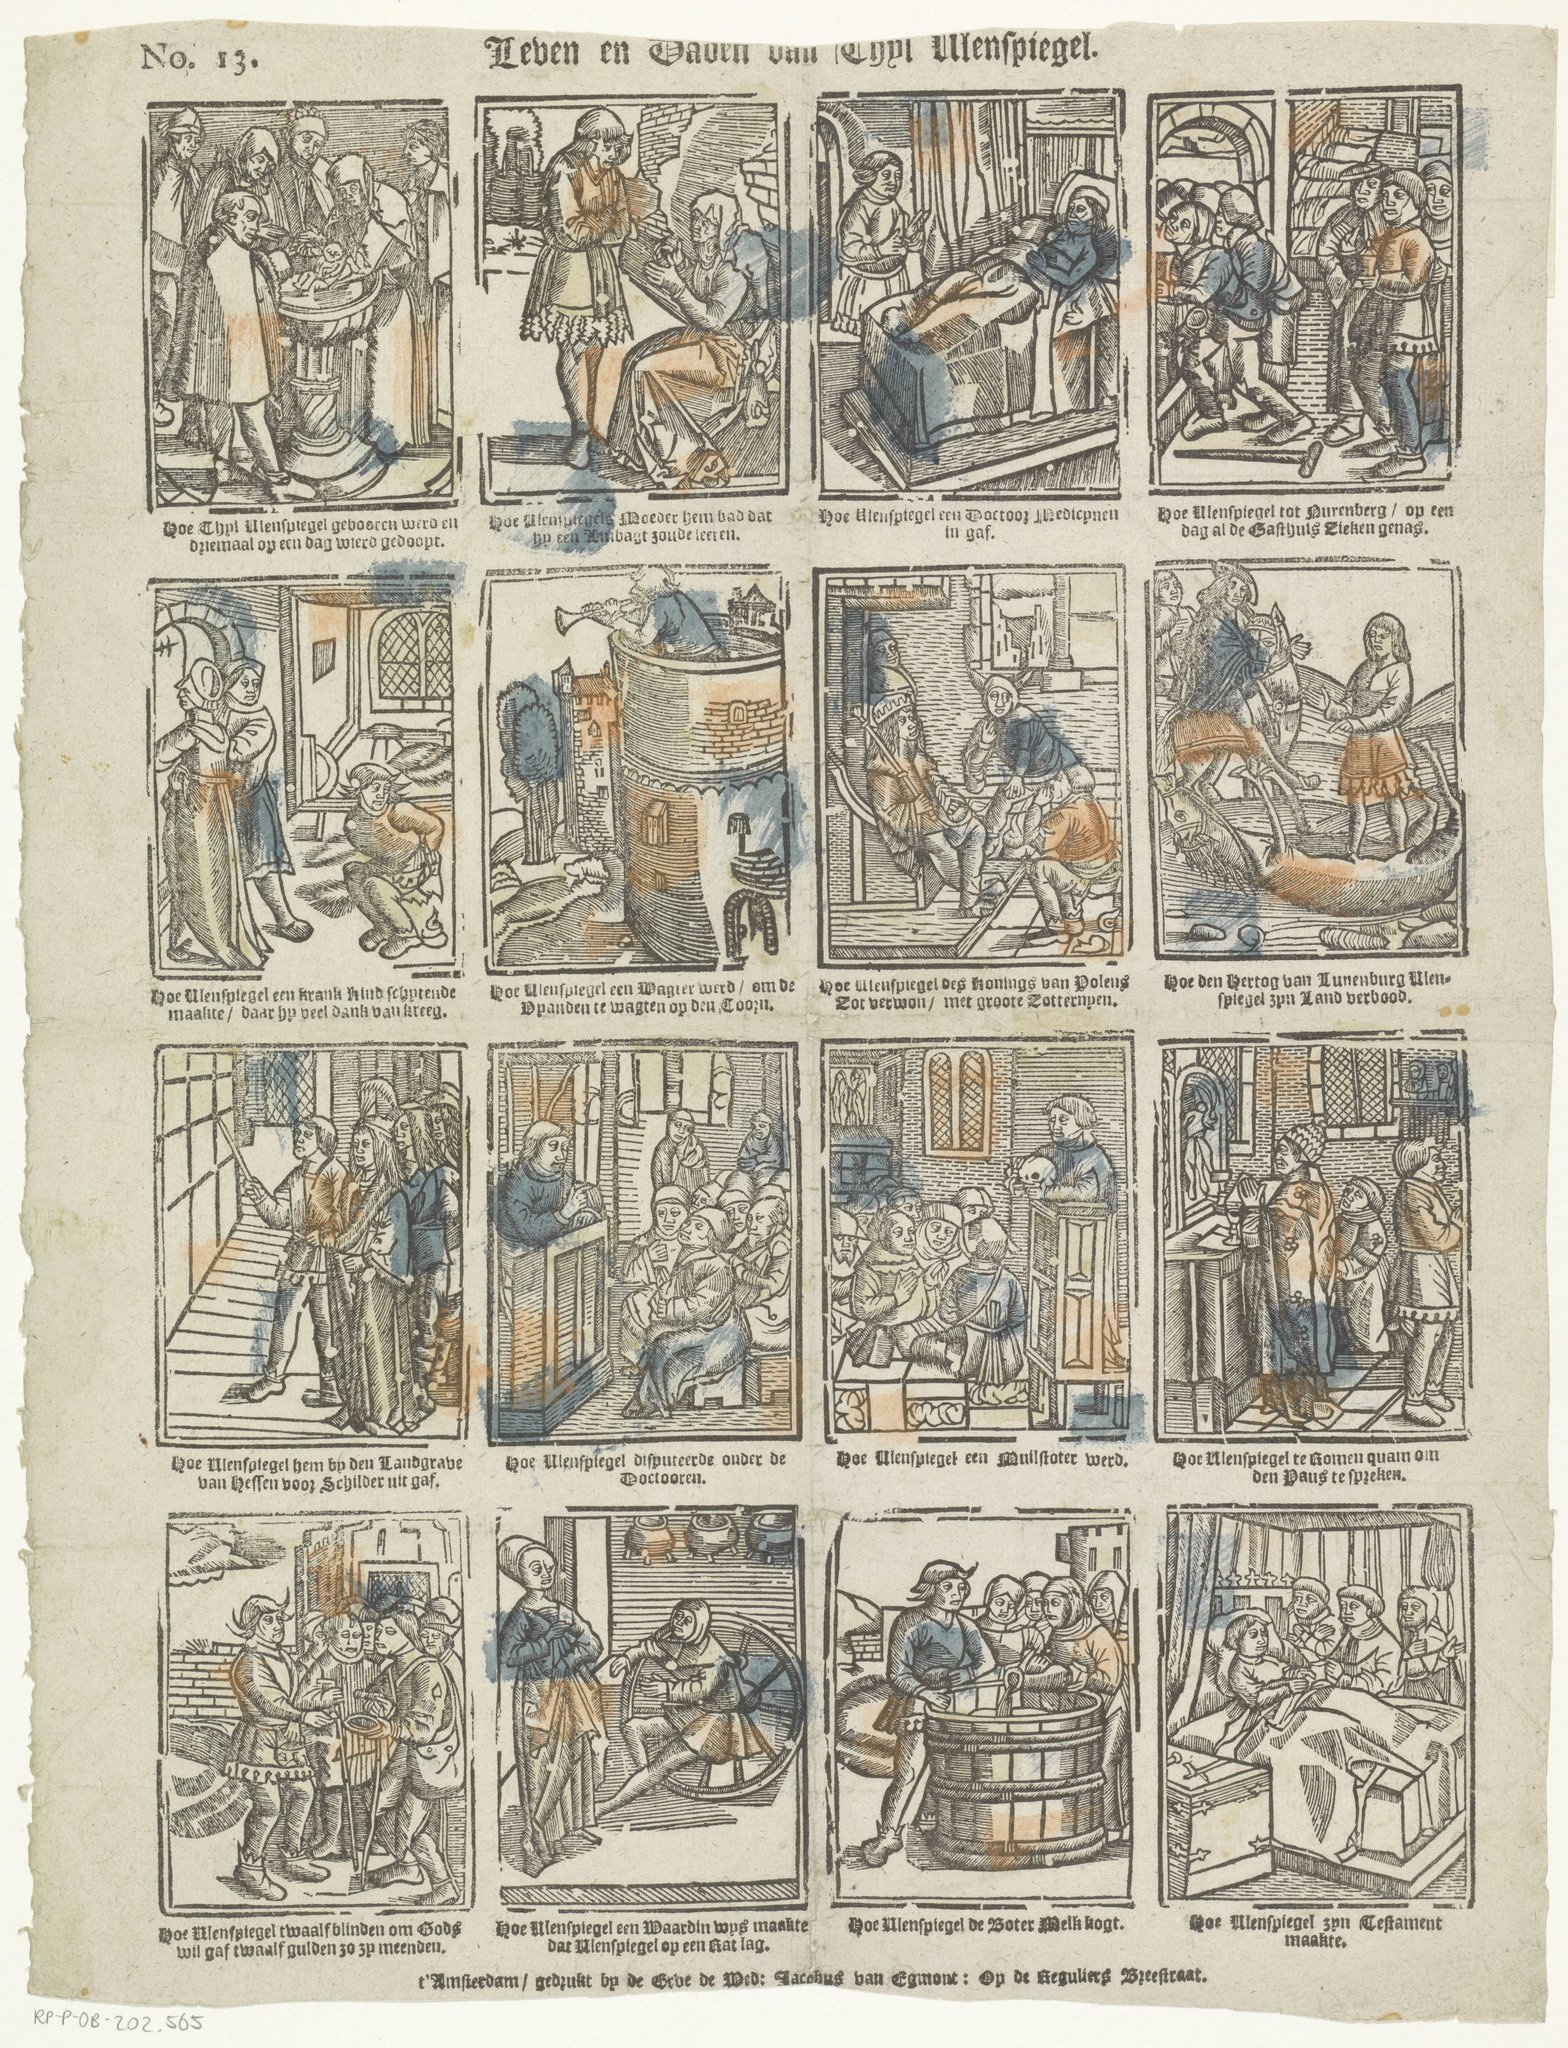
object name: popular print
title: Leven en daden van Thyl Ulenspiegel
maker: Anonymous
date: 1761-1804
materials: paper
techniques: colour, letterpress printing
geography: amsterdam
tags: eulenspiegel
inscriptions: collector's mark: Lugt 2760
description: Blad met 16 voorstellingen over het leven van Tijl Uilenspiegel. Onder elke afbeelding een tweeregelig onderschrift. Genummerd linksboven: No. 13.